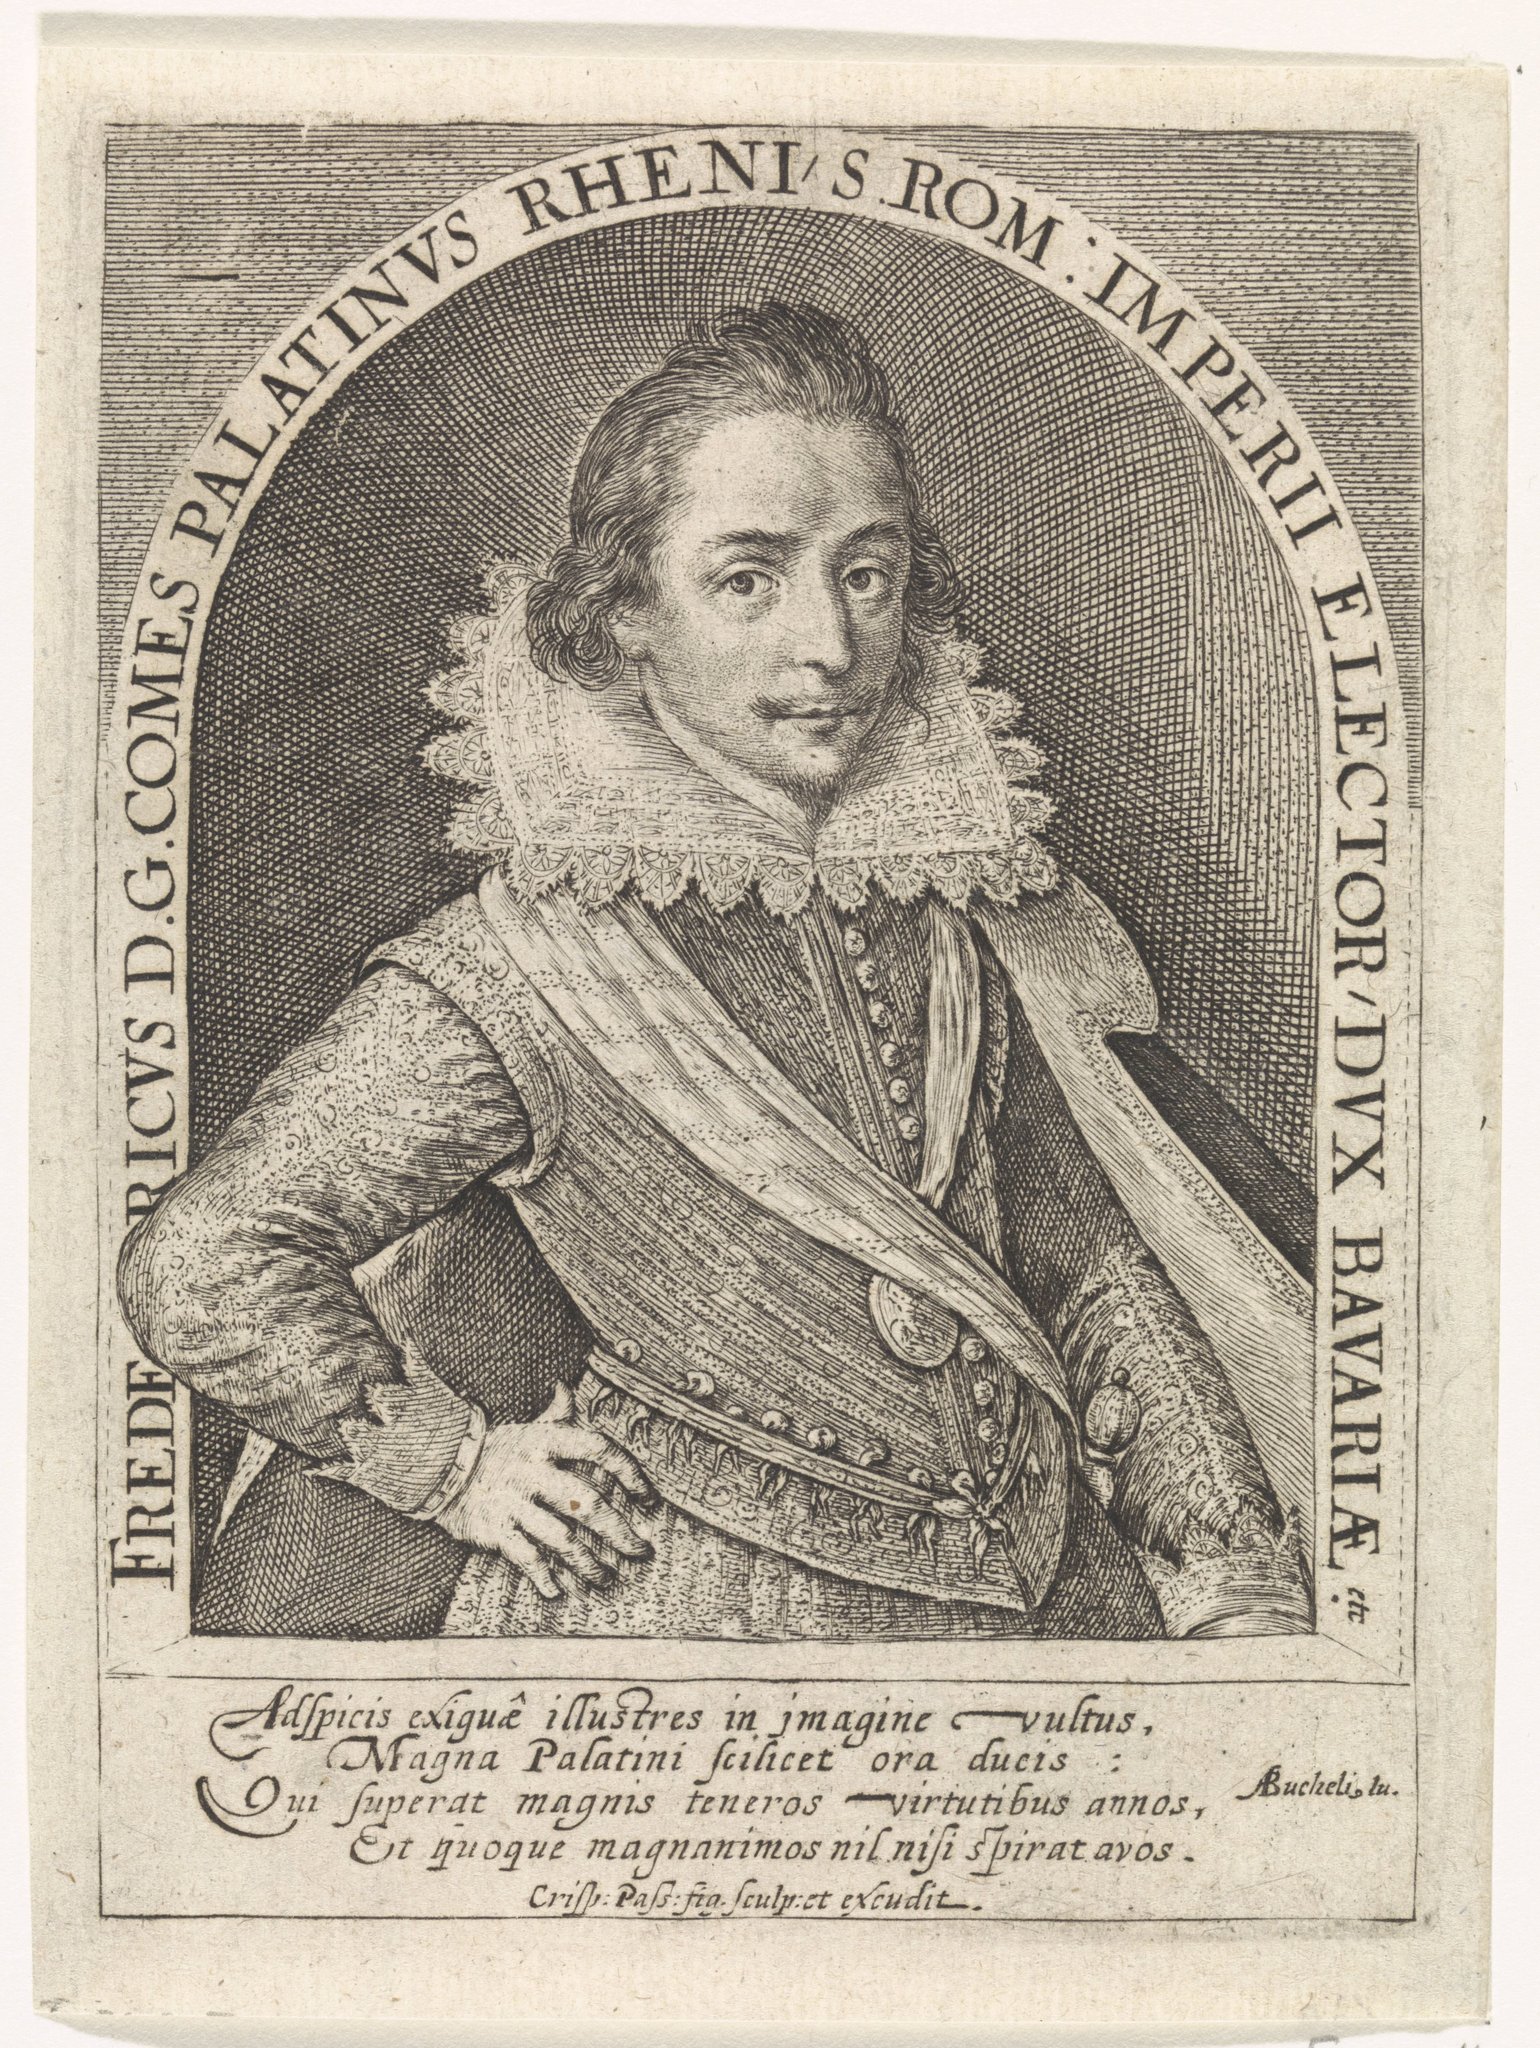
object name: print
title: Portret van Frederik V, keurvorst van de Palts, koning van Bohemen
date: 1610-1637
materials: paper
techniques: engraving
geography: utrecht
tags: amberg, frederik v (keurvorst van de palts, koning van bohemen)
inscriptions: collector's mark: Lugt 2228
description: Portret van Frederik V, keurvorst van de Palts, koning van Bohemen. In het randschrift van de omlijsting de naam en functie van de geportretteerde in het Latijn. In de marge een vierregelig lofdicht in het Latijn.